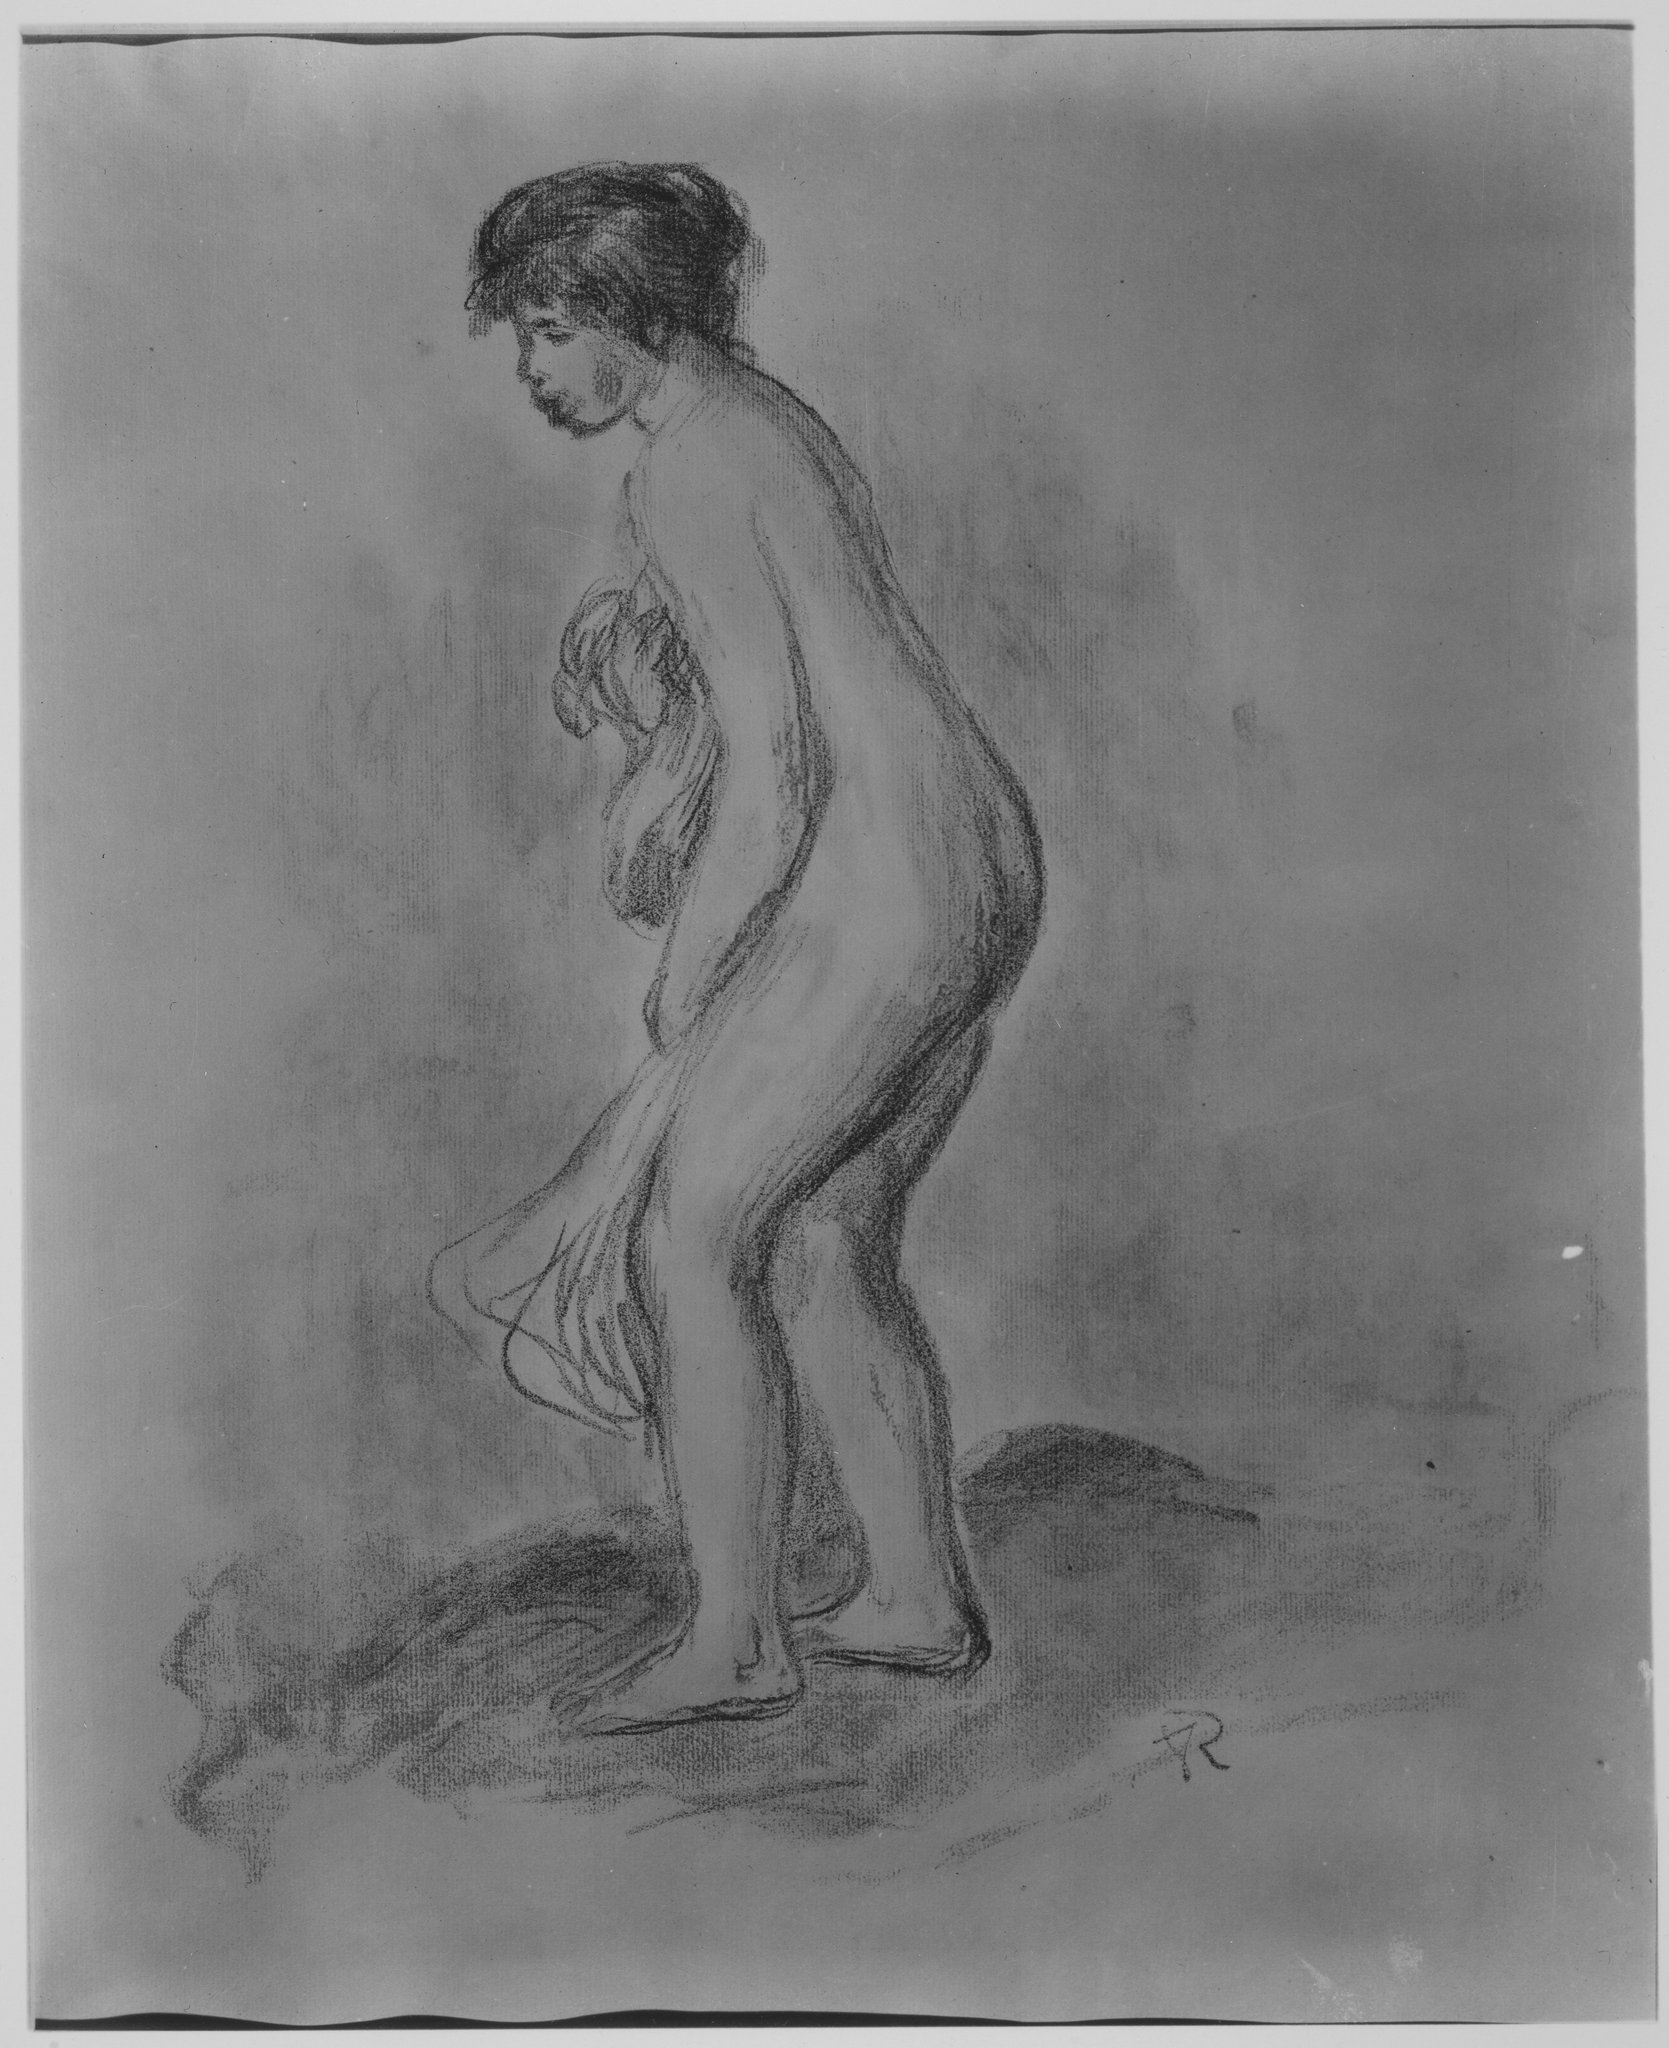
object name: print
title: Standing Bather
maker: pierre auguste renoir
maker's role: artist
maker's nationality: french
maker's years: 1841-1919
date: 1896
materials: paper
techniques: lithograph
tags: female nudes